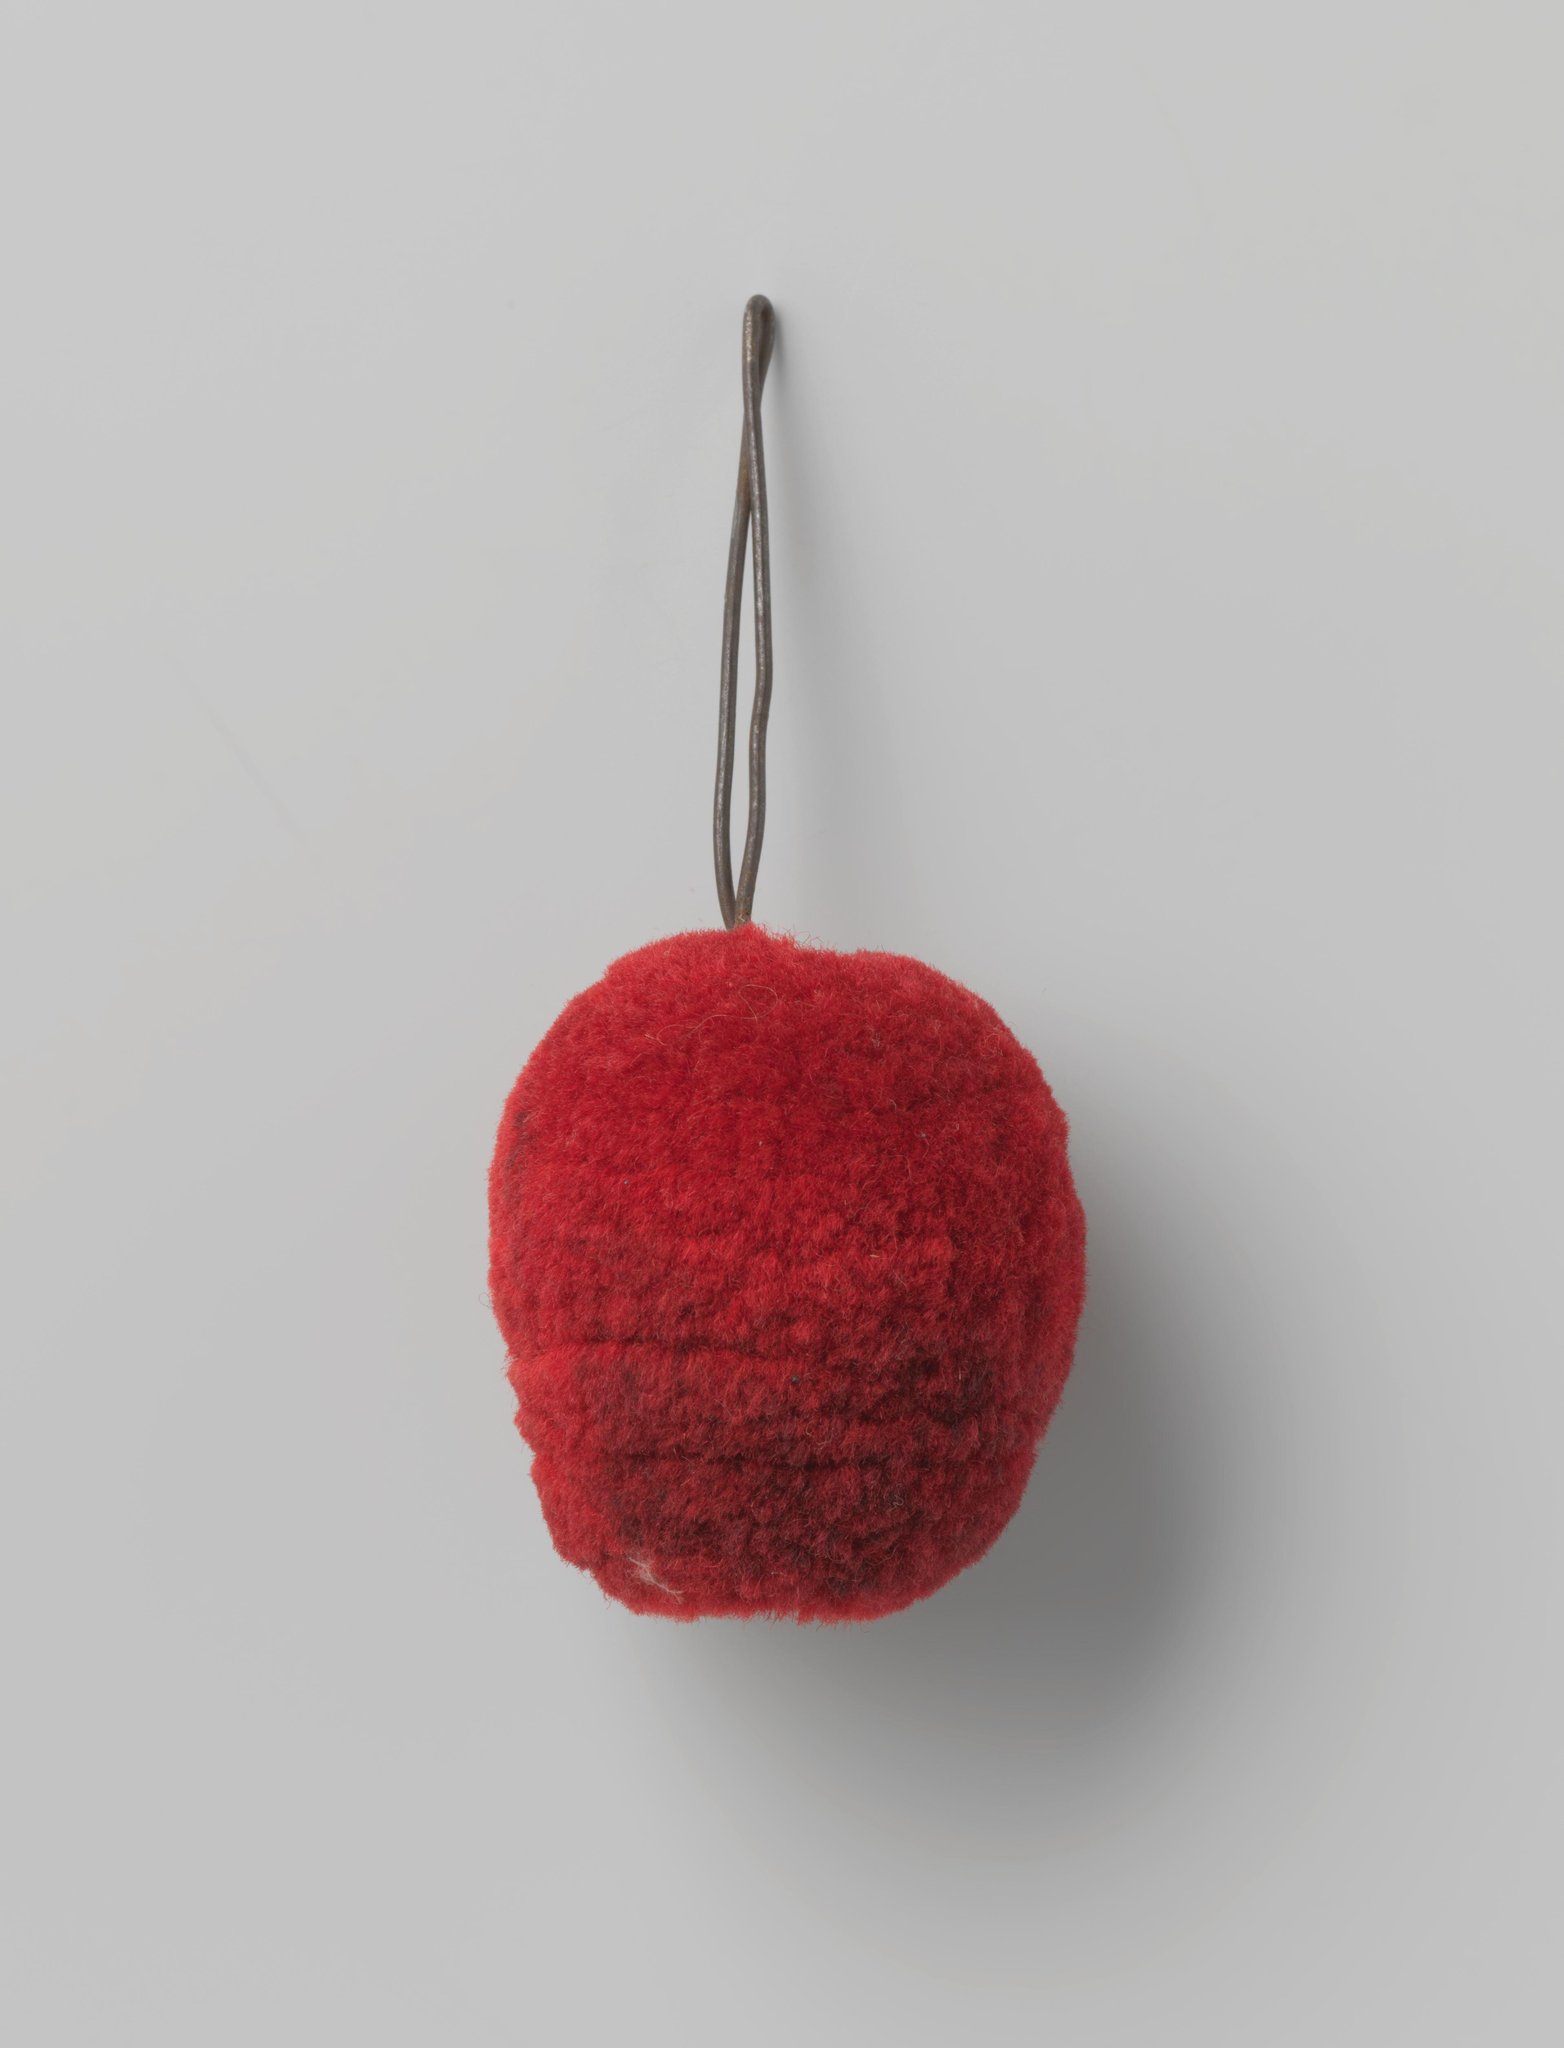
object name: bal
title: Bal voor sjako model 1828, flankeur der schutterij ca. 1830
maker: Anonymous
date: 1830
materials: metal, wool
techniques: stitching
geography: netherlands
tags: netherlands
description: Bal voor sjako model 1828. Bal van rode wol met wit metalen draad en kern van hout. In twee ballen gaten voor insteken tulp met pluim. Aan een der draden etiket: Rijksmuseum, Amsterdam. Voor flankeur der schutterij: manschappen, onderofficieren, officieren ca. 1830.